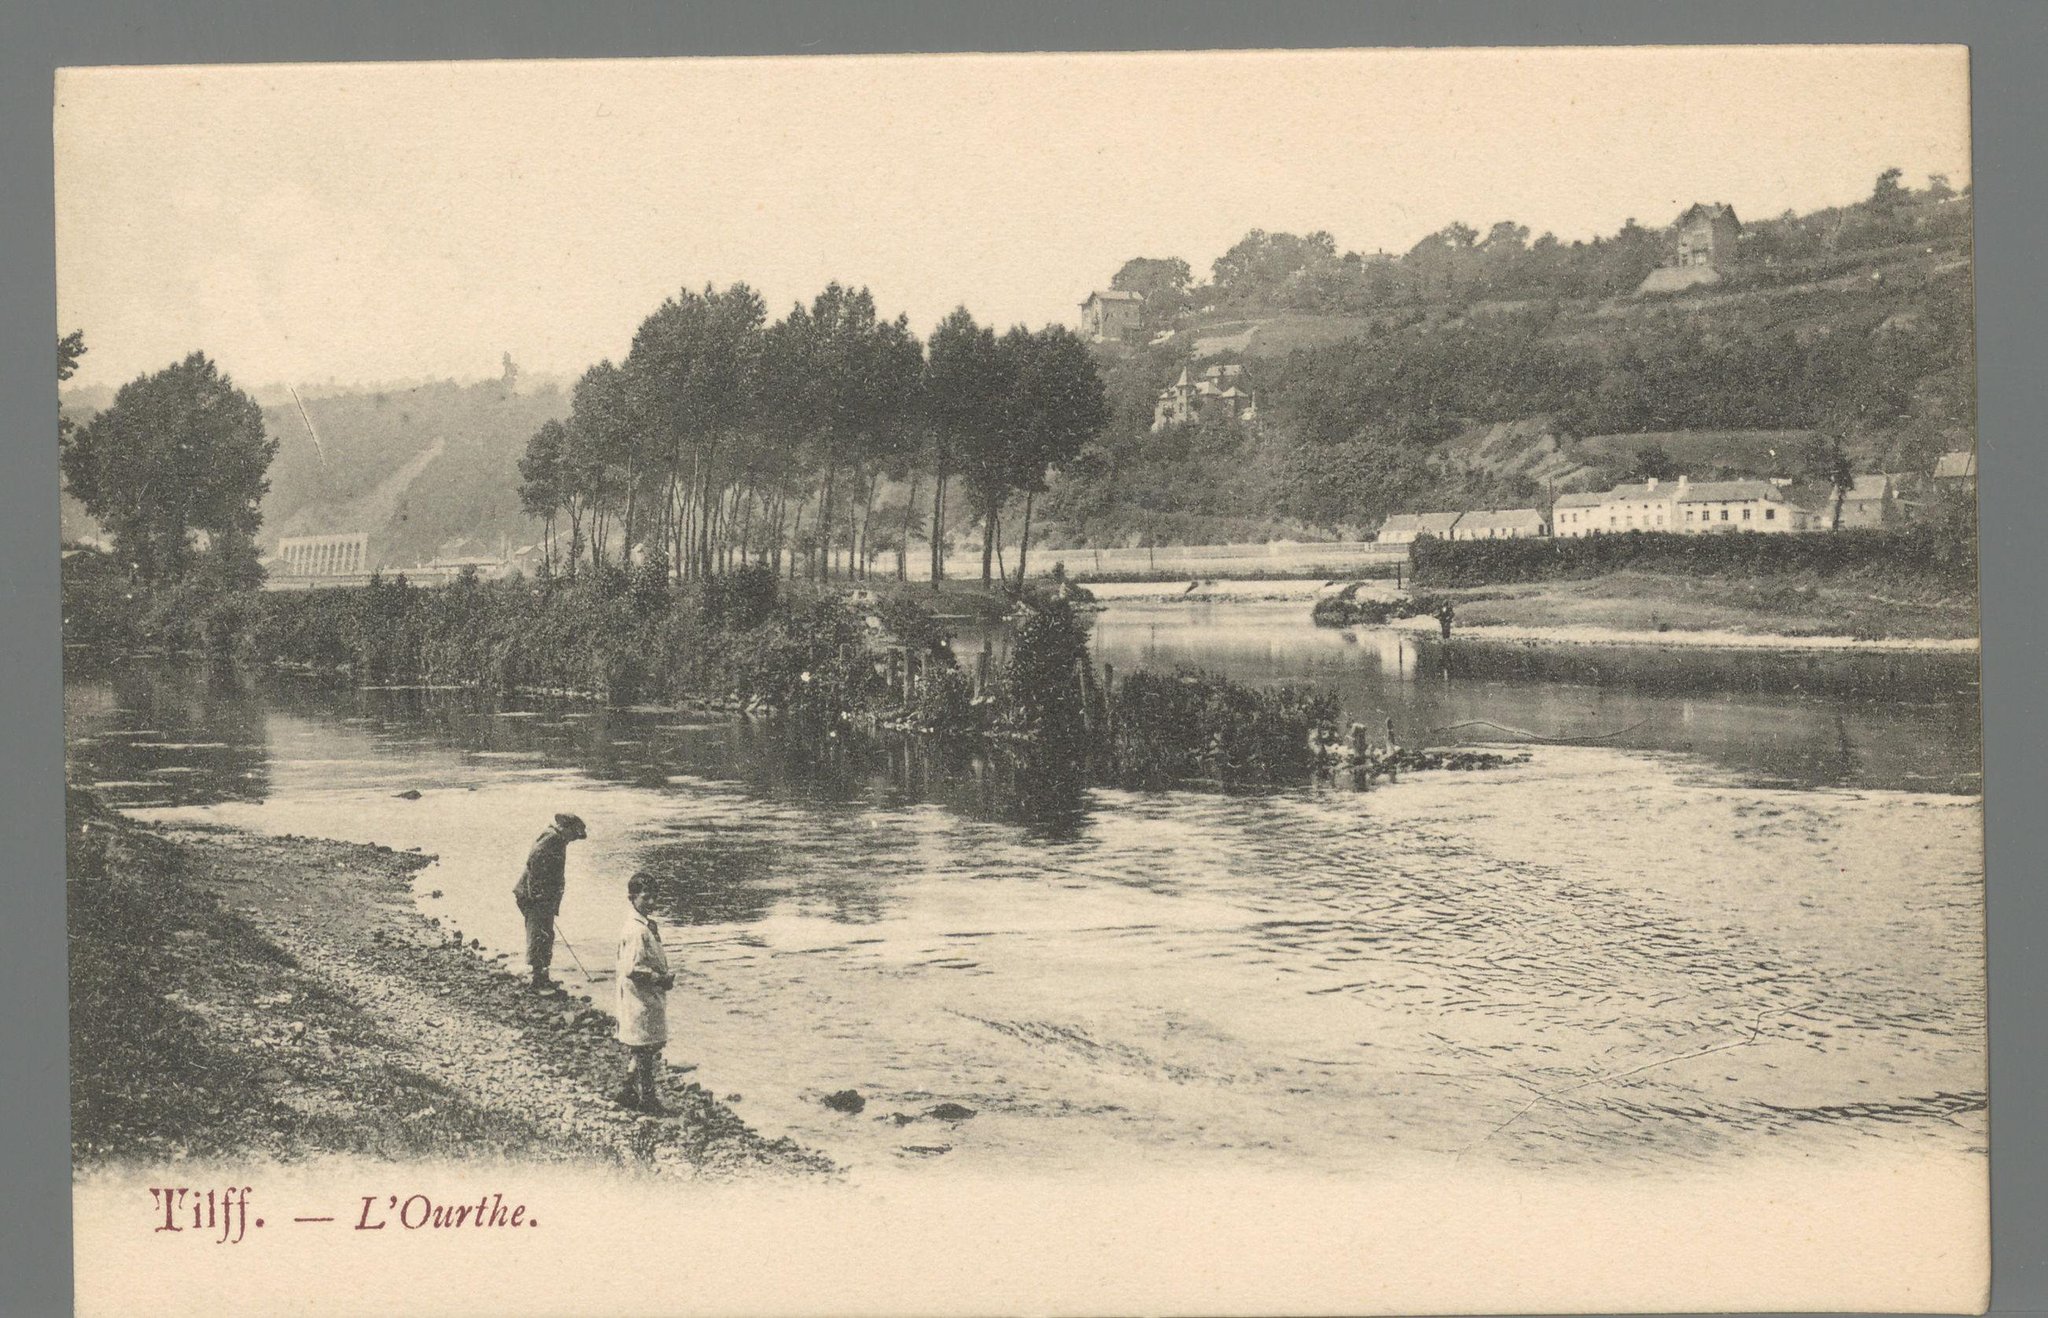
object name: photomechanical print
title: Tilff. L'Ourthe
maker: Anonymous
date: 1897-1906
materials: cardboard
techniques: photograph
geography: tilff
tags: river (+ landscape with figures, staffage), angling